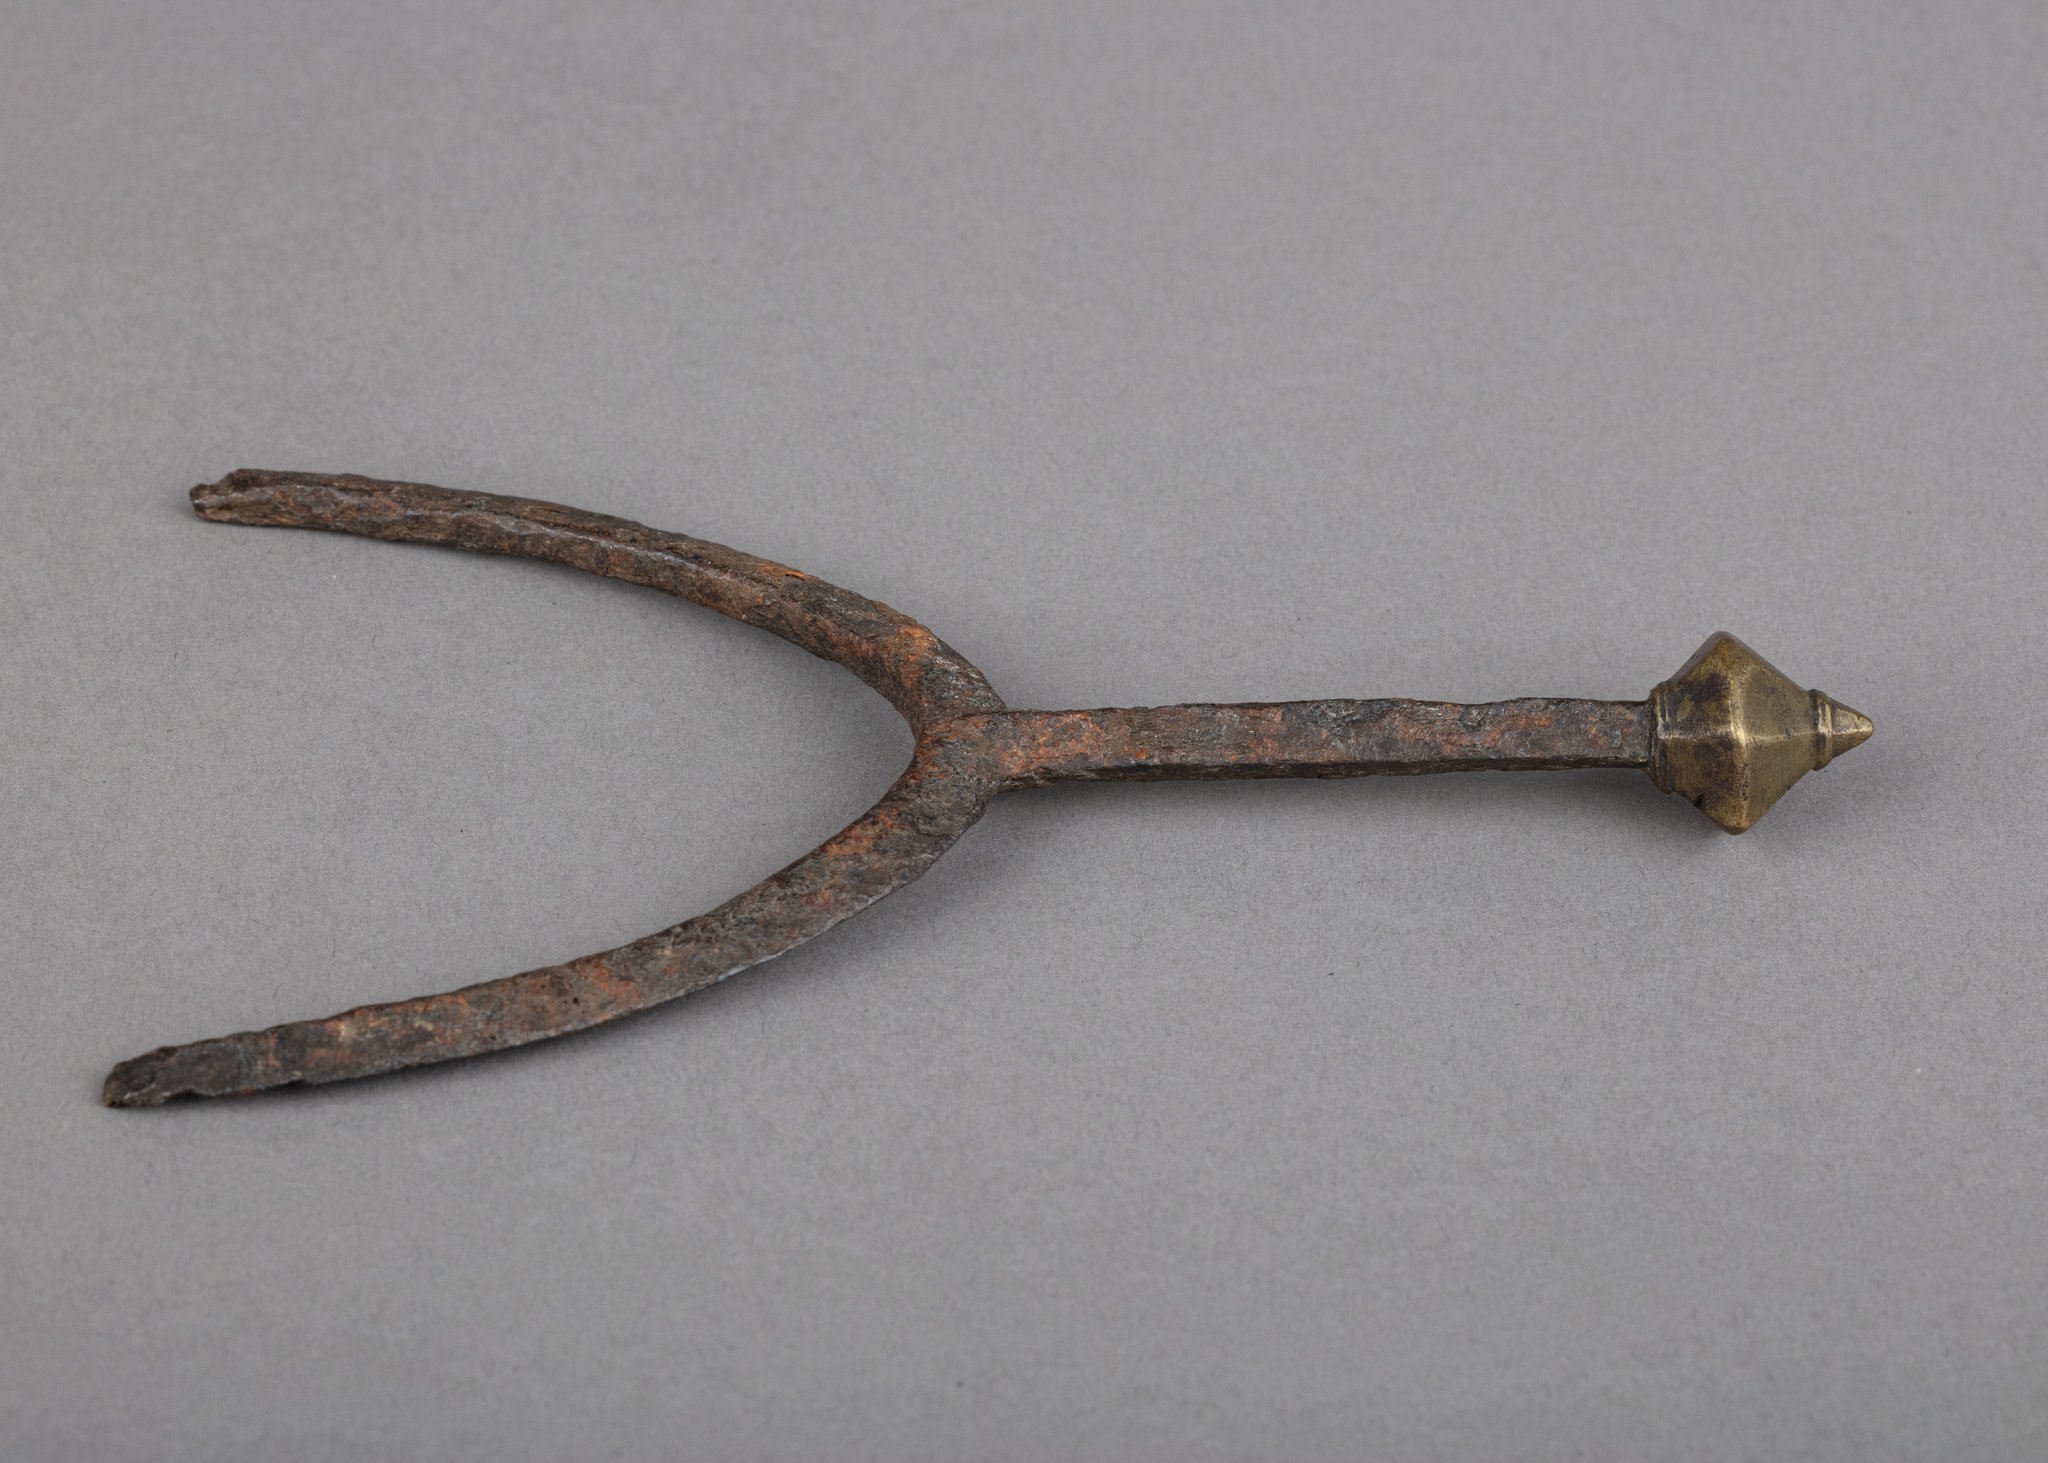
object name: spur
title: Prick Spur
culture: french or german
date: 1001-1100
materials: copper alloy, metal alloy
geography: germany